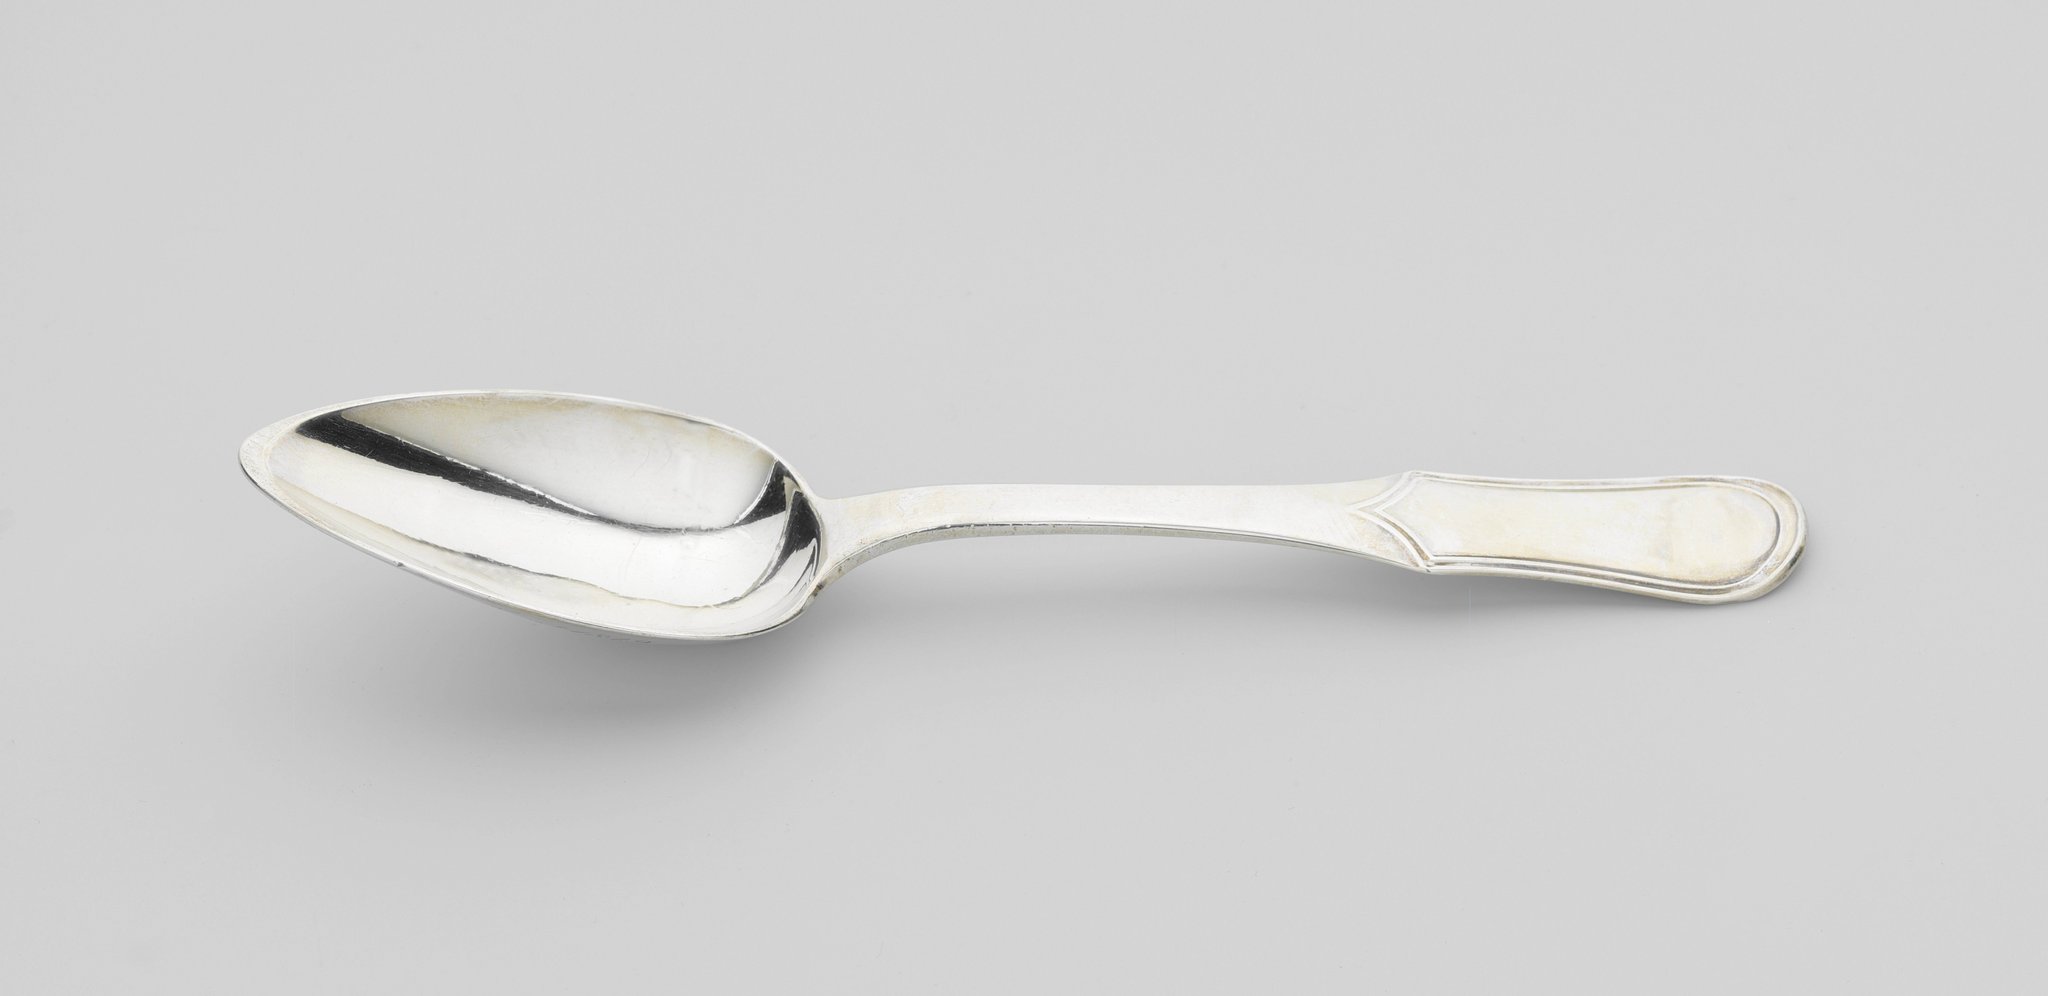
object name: spoon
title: Lepel met geboorte-inscriptie: Pieter de Clercq, Geboren 21 Jany, 1849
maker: hendrik helweg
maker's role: silversmith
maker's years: 1802-1858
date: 1850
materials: silver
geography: amsterdam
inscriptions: inscription: ‘Pieter de Clerq, Geboren 21 Jany"1849.’, assay office mark, alloy mark, date letter: ‘Q’, maker's mark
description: De spits eivormige bak is door middel van enkel lof verbonden met de platte, gebogen steel, die zich verbreedt naar het licht ingesnoerde spatelvormige uiteinde. De onderzijde van de steel wordt omgeven door een filetrand en aan de bovenzijde loopt een dergelijke rand rond de spatel. Op de onderzijde van de bak is gegraveerd: Pieter de Clercq, Geboren 21 Jany" 1849.